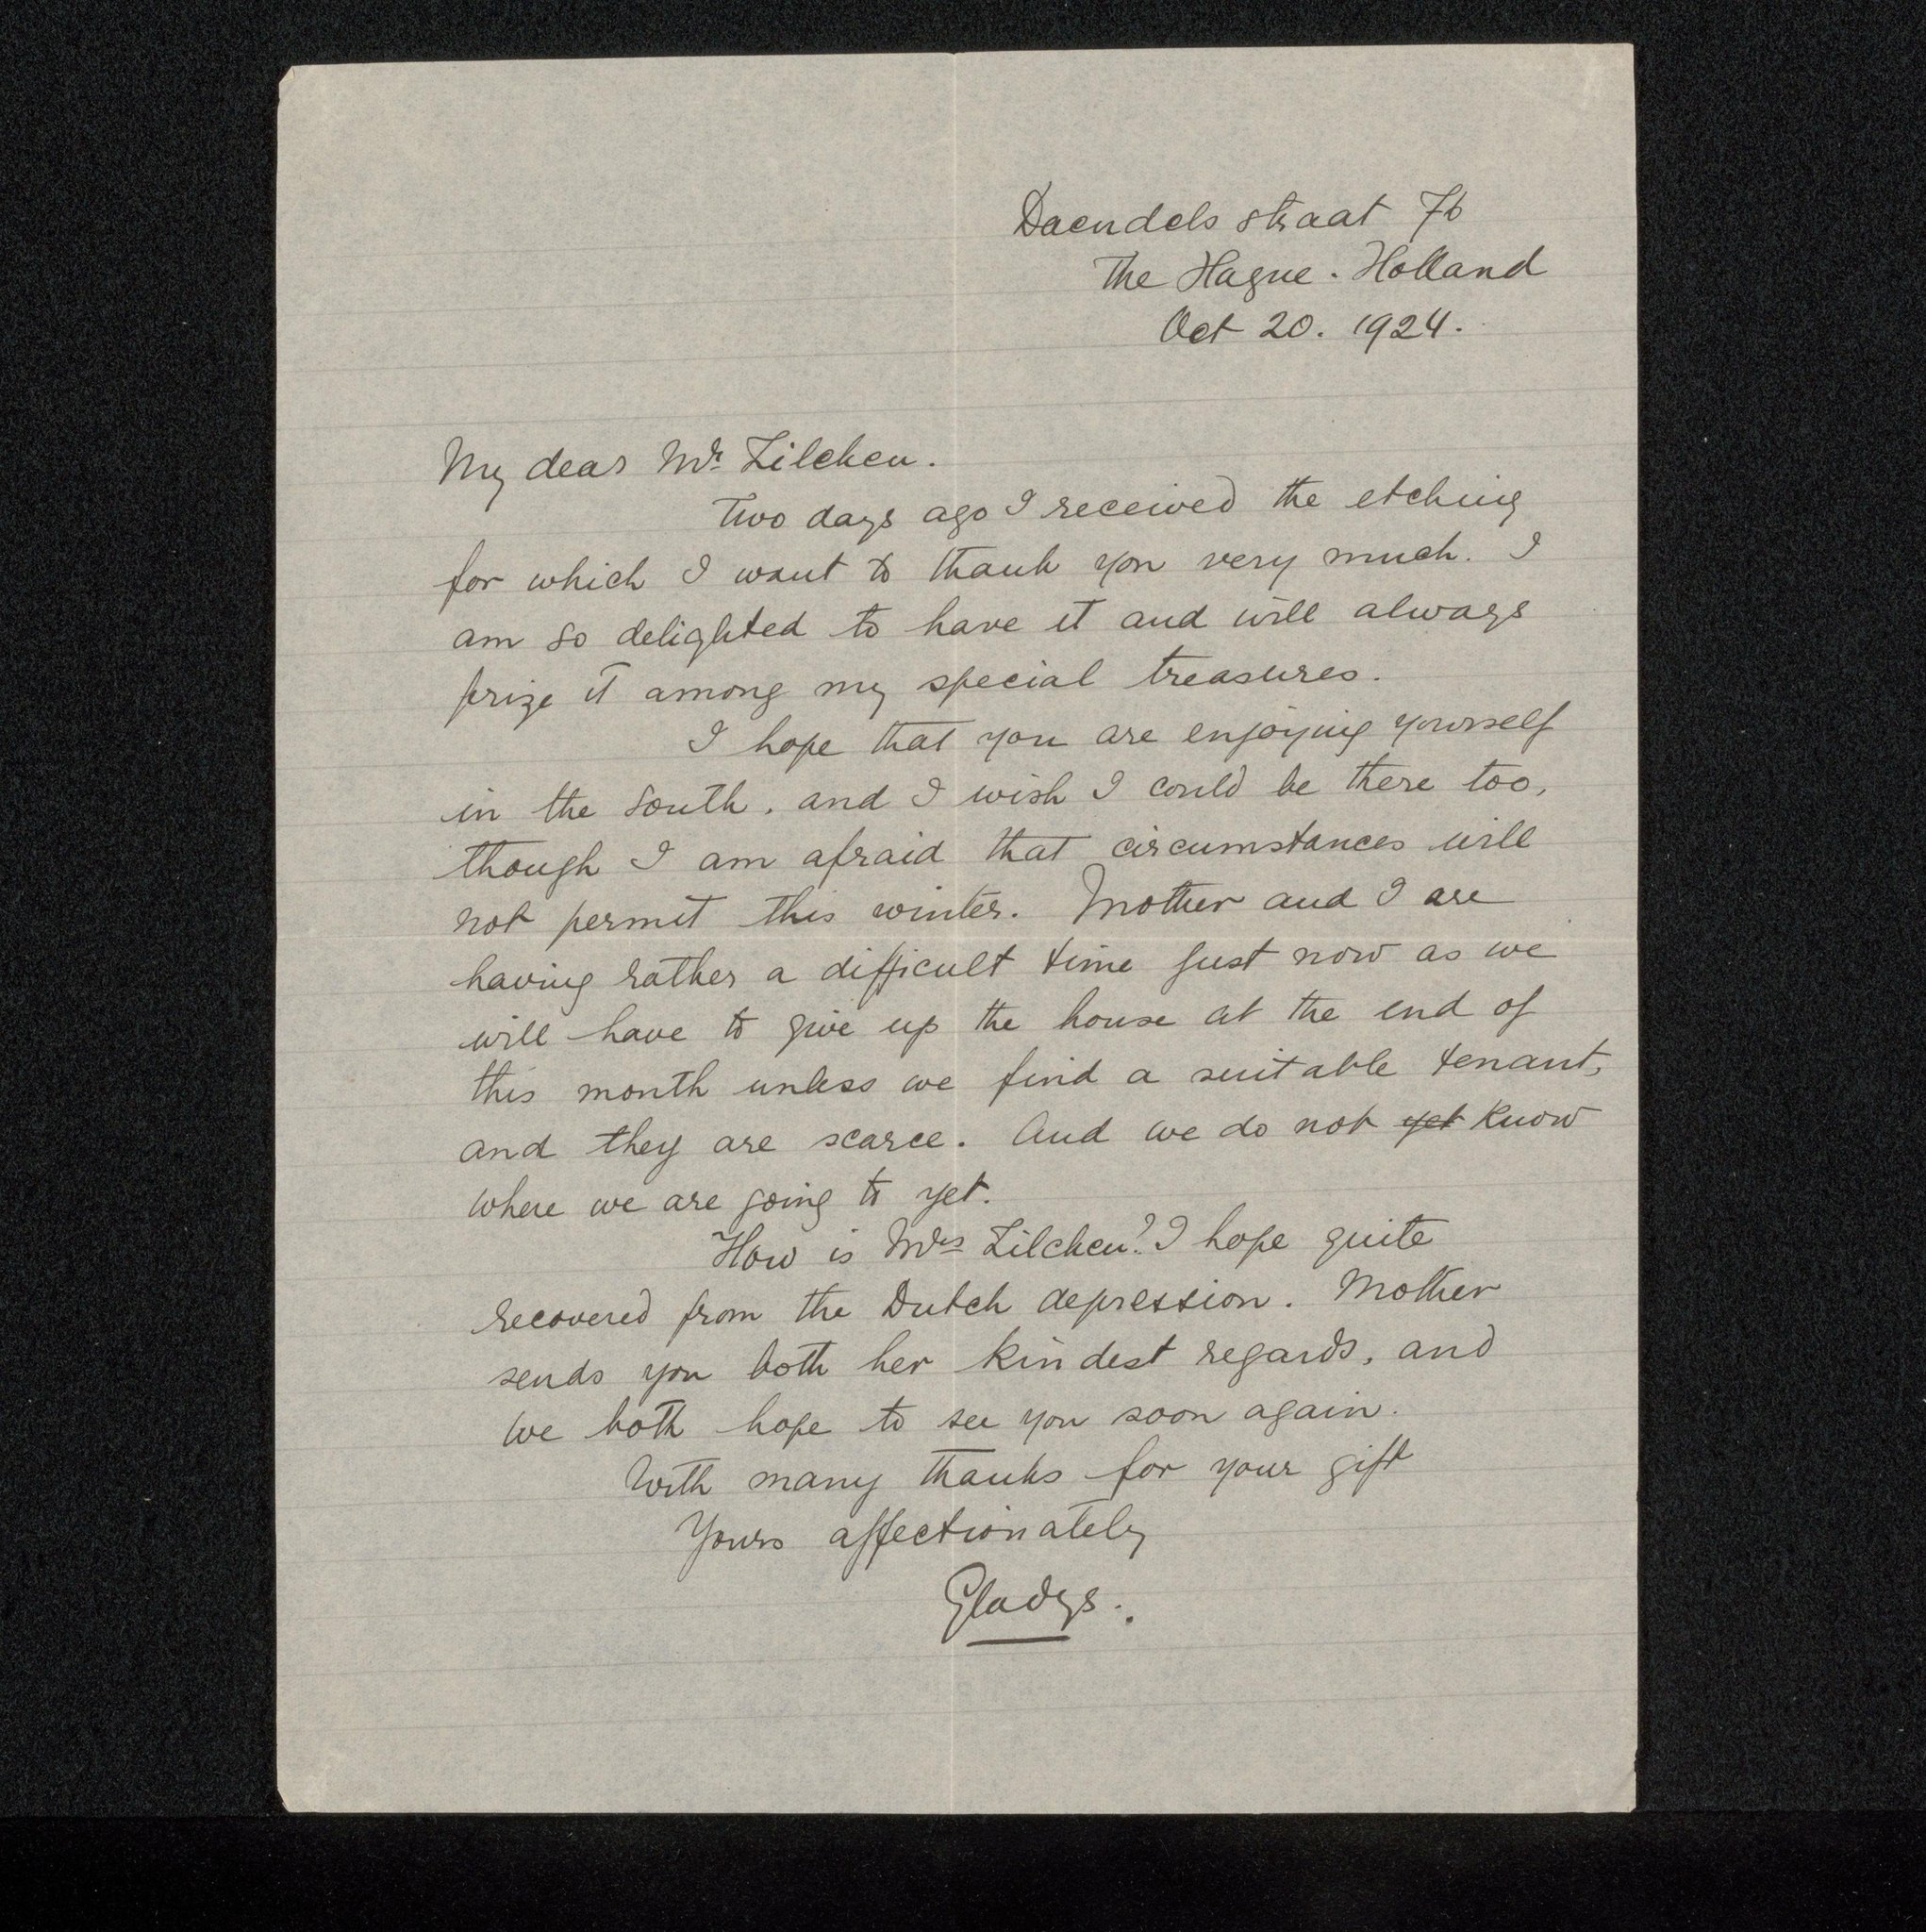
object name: letter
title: Brief aan Philip Zilcken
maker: gladys anna eleanora hadkinson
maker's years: 1895-1925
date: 1924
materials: ink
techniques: pen, writing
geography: the hague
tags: the hague, painter, draughtsman, philip zilcken, the graphic arts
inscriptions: collector's mark: ‘RPK’